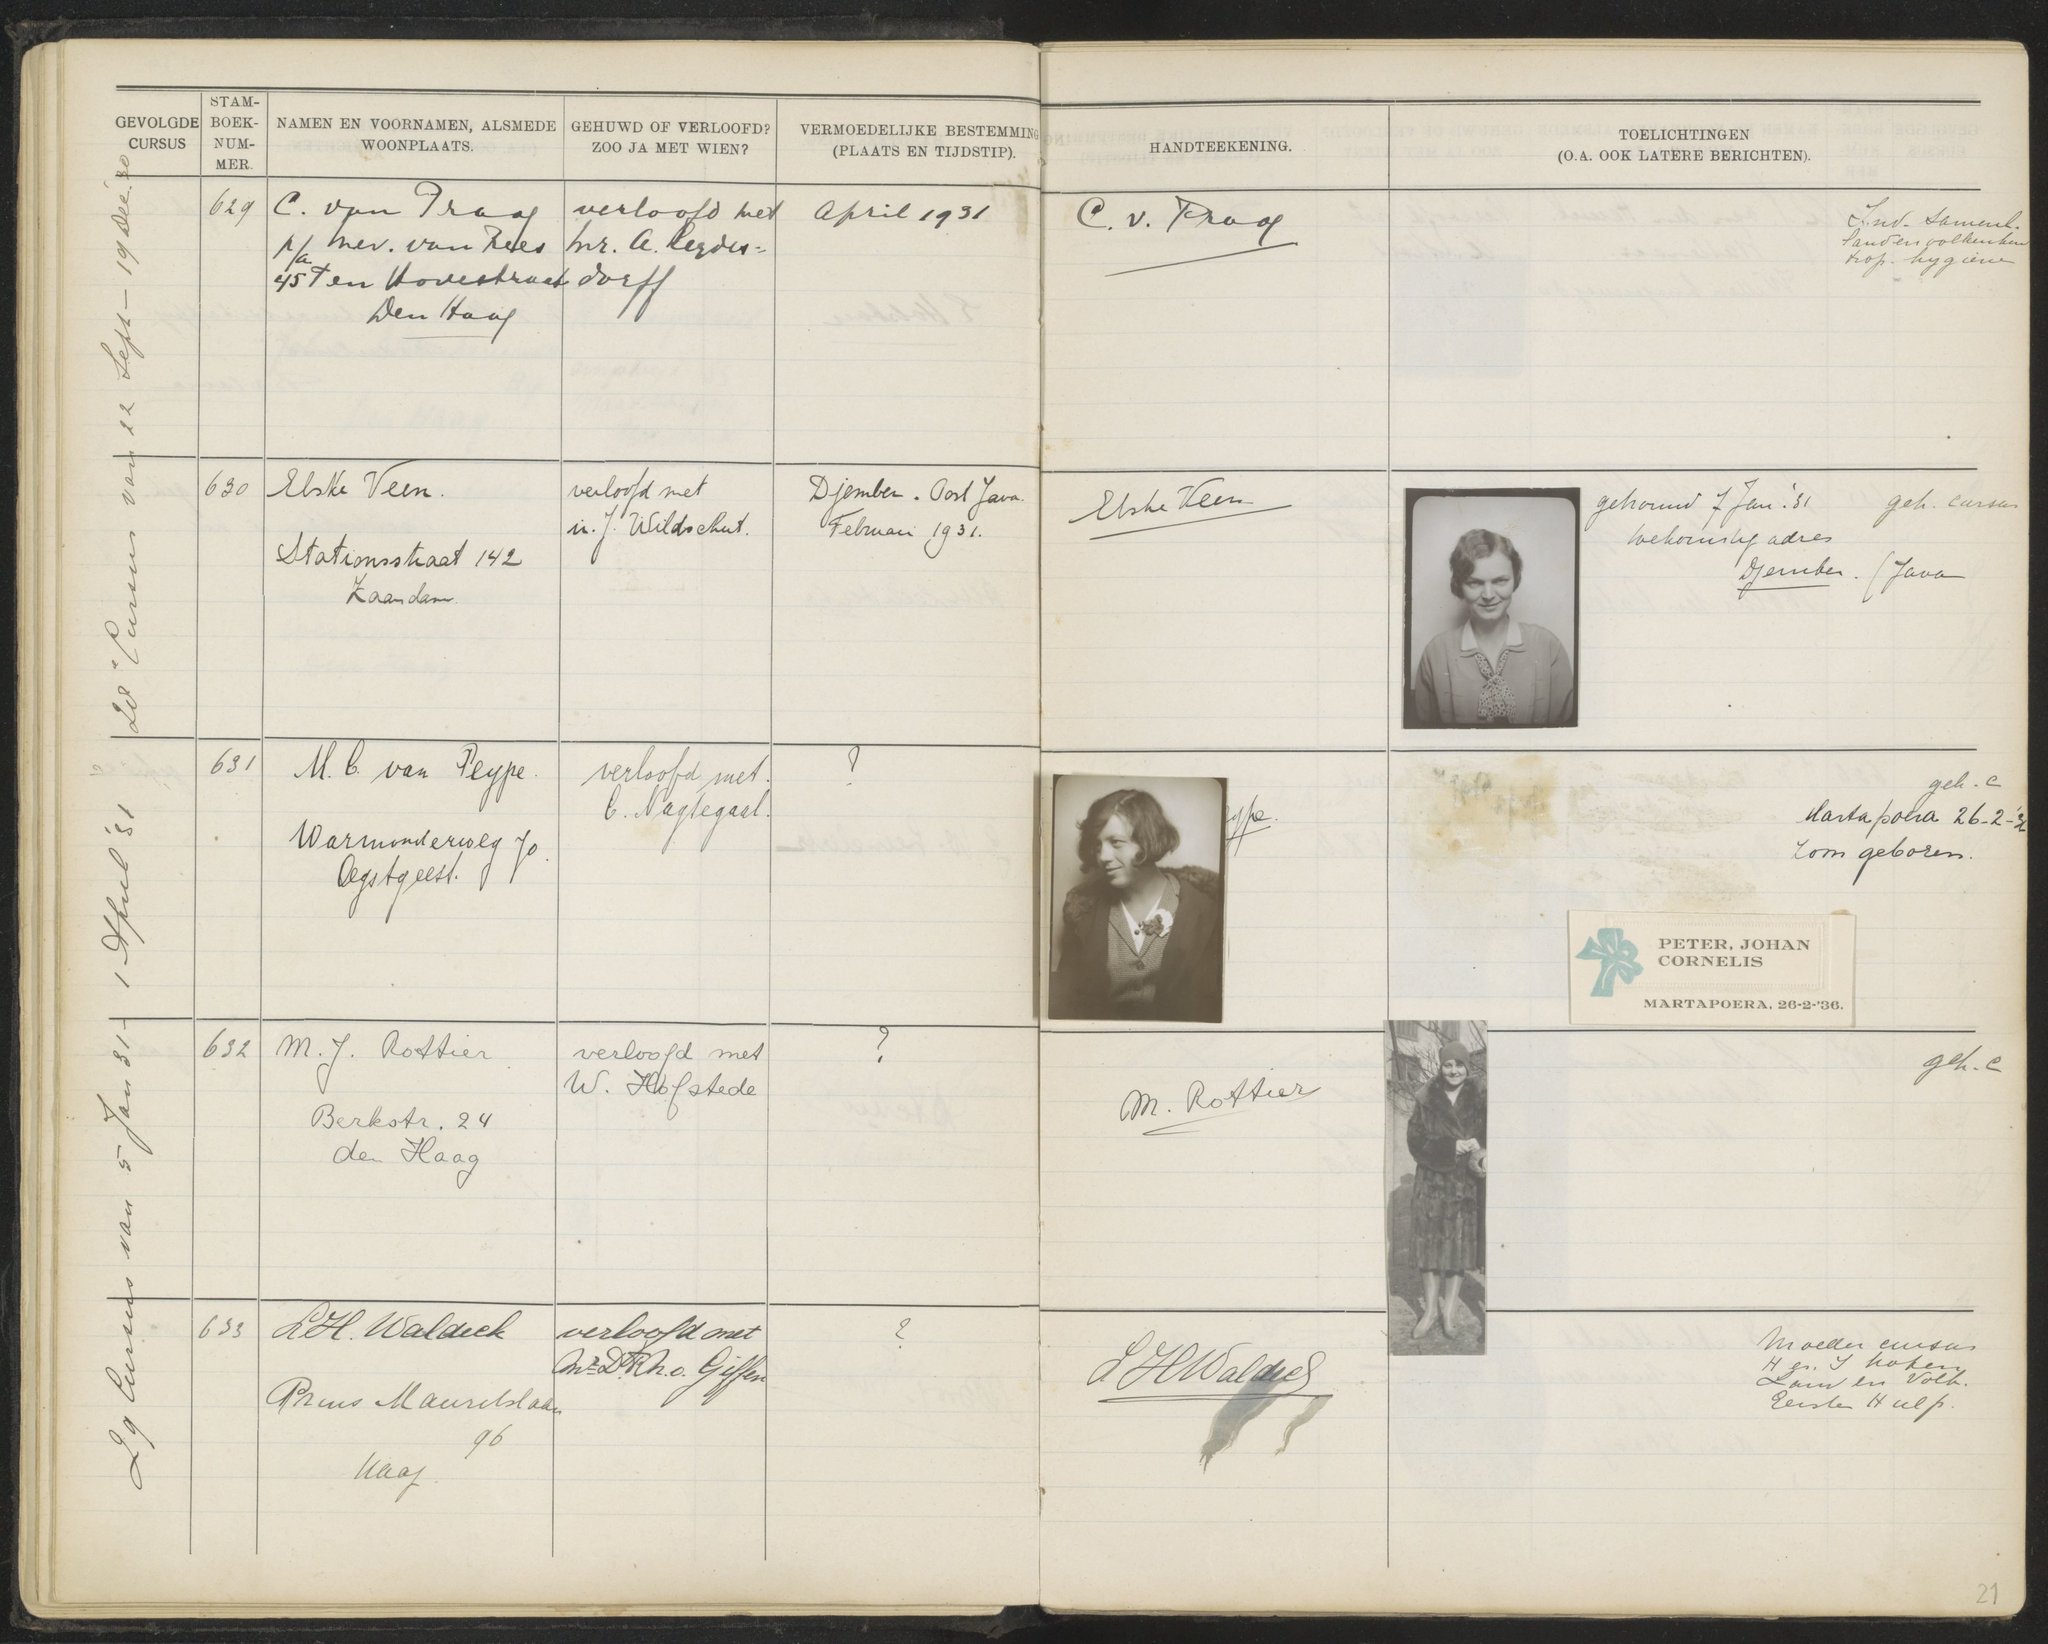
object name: photograph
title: Blad 21 uit Stamboek van de leerlingen der Koloniale School voor Meisjes en Vrouwen te 's-Gravenhage deel II (1930-1949)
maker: Anonymous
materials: paper, photographic support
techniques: photography, printing, writing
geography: the hague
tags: further education (+ pupil), further education, the hague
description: Twee pagina's met gegevens van de deelnemers aan de 28e en 29e driemaandelijkse cursus resp. van 22 september tot en met 19 december 1930 en 5 januari tot en met 1 april 1931, stamboeknummers 629 tot en met 633. Onderdeel van Stamboek van de leerlingen der Koloniale School voor Meisjes en Vrouwen te 's-Gravenhage deel II (1930-1949).